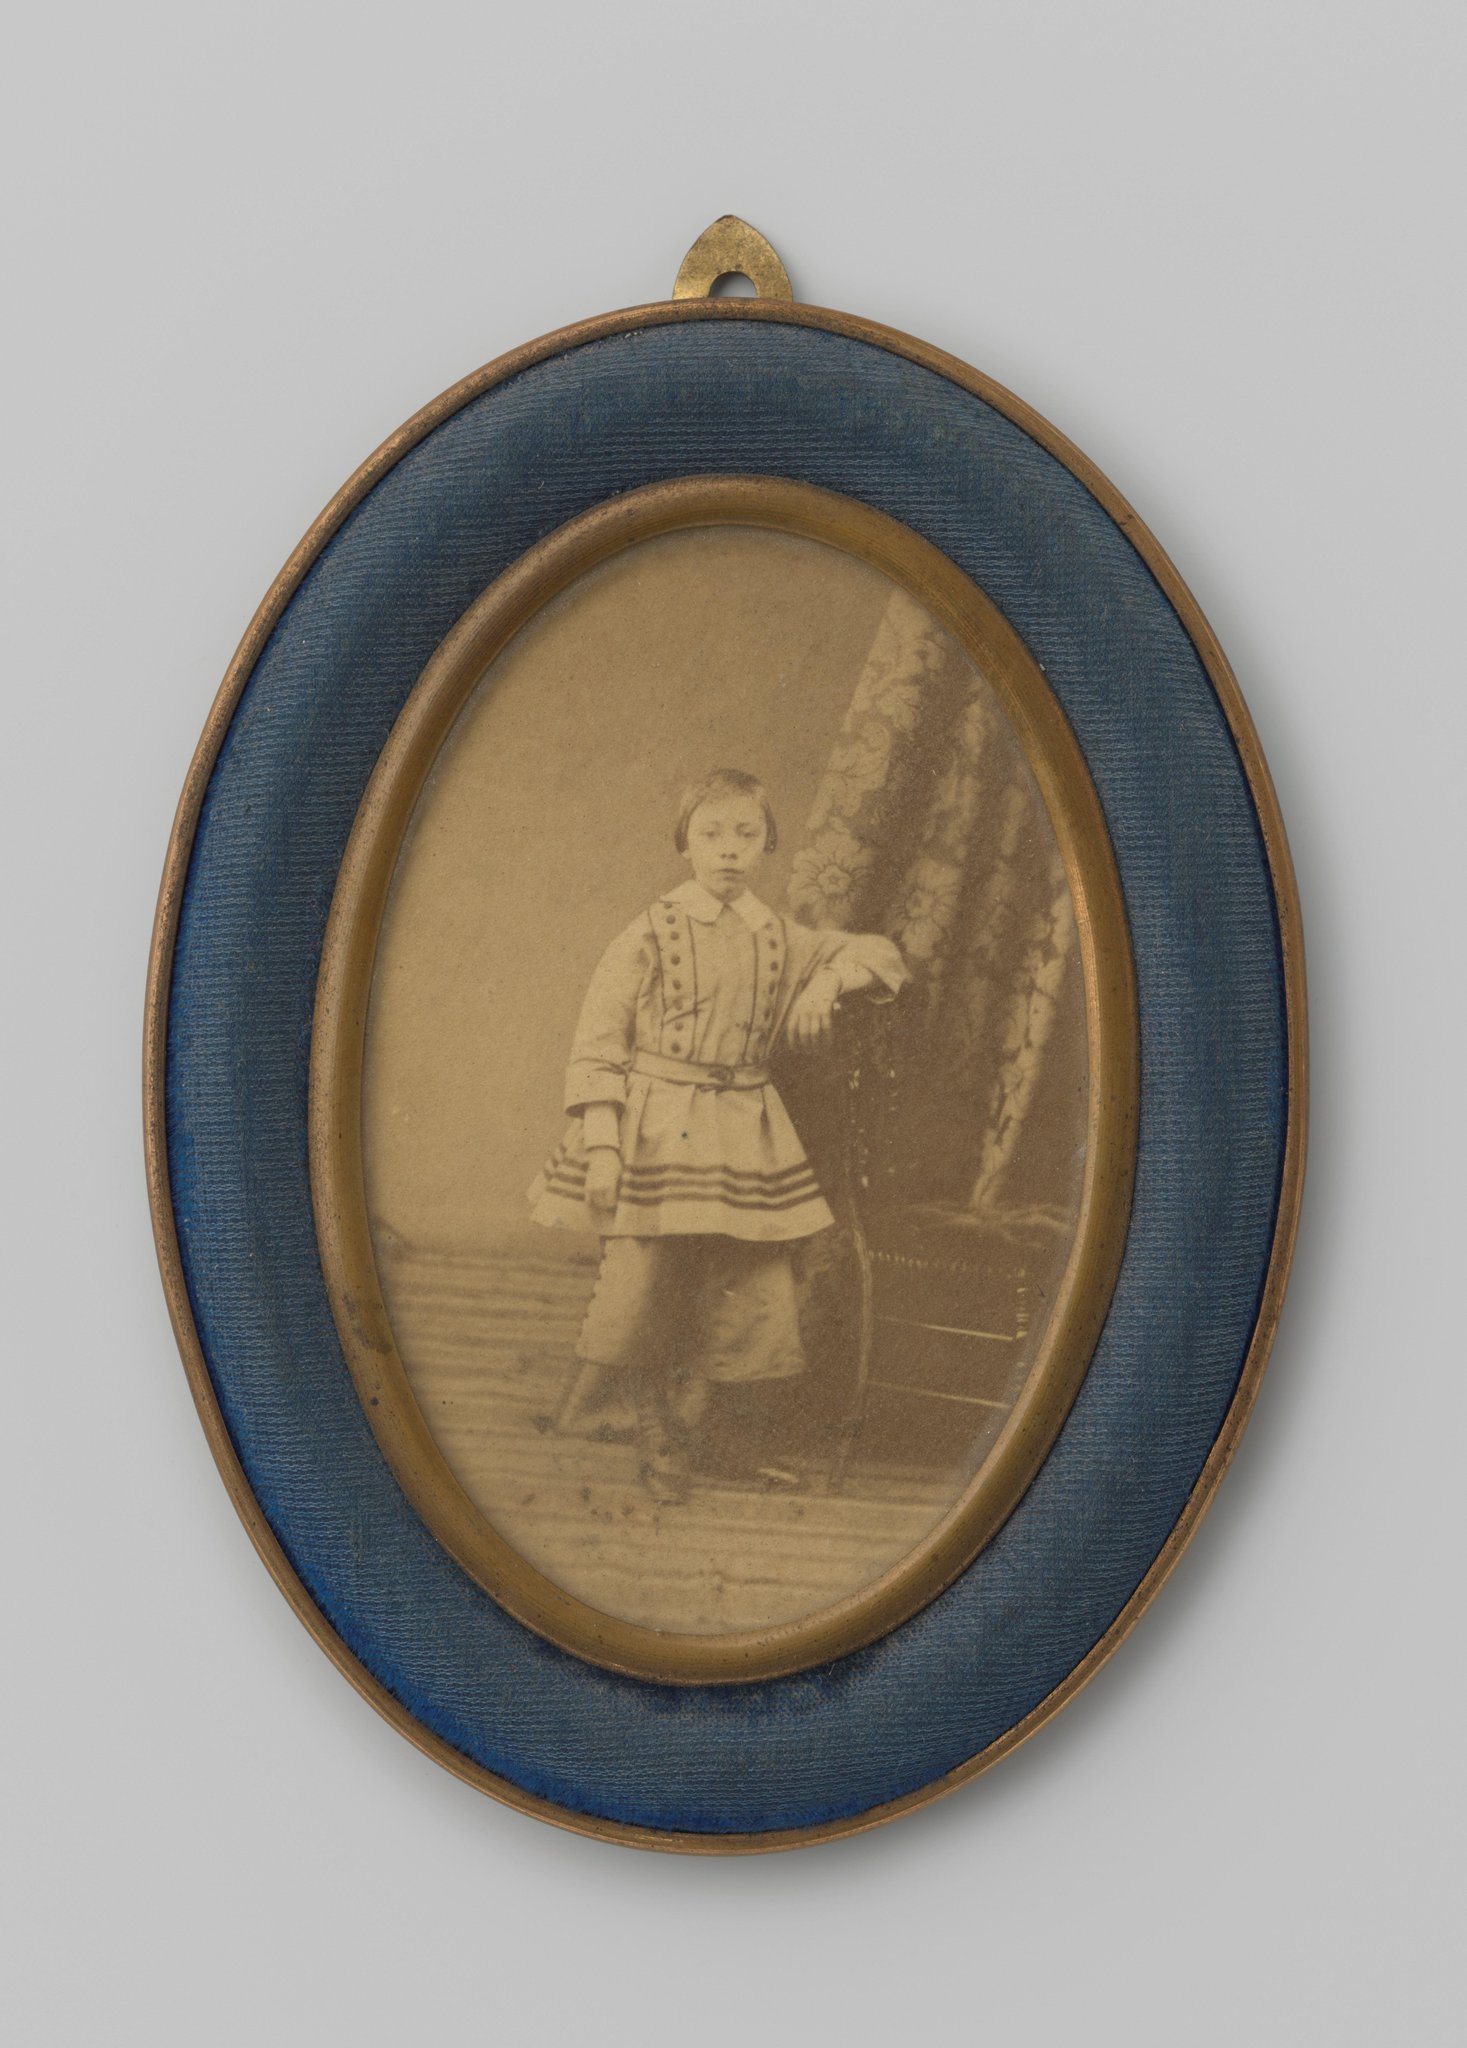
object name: frame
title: Portret van een onbekend kind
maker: Anonymous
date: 1880-1900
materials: glass, metal, paper, textile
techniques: albumen print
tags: child, anonymous historical person portrayed